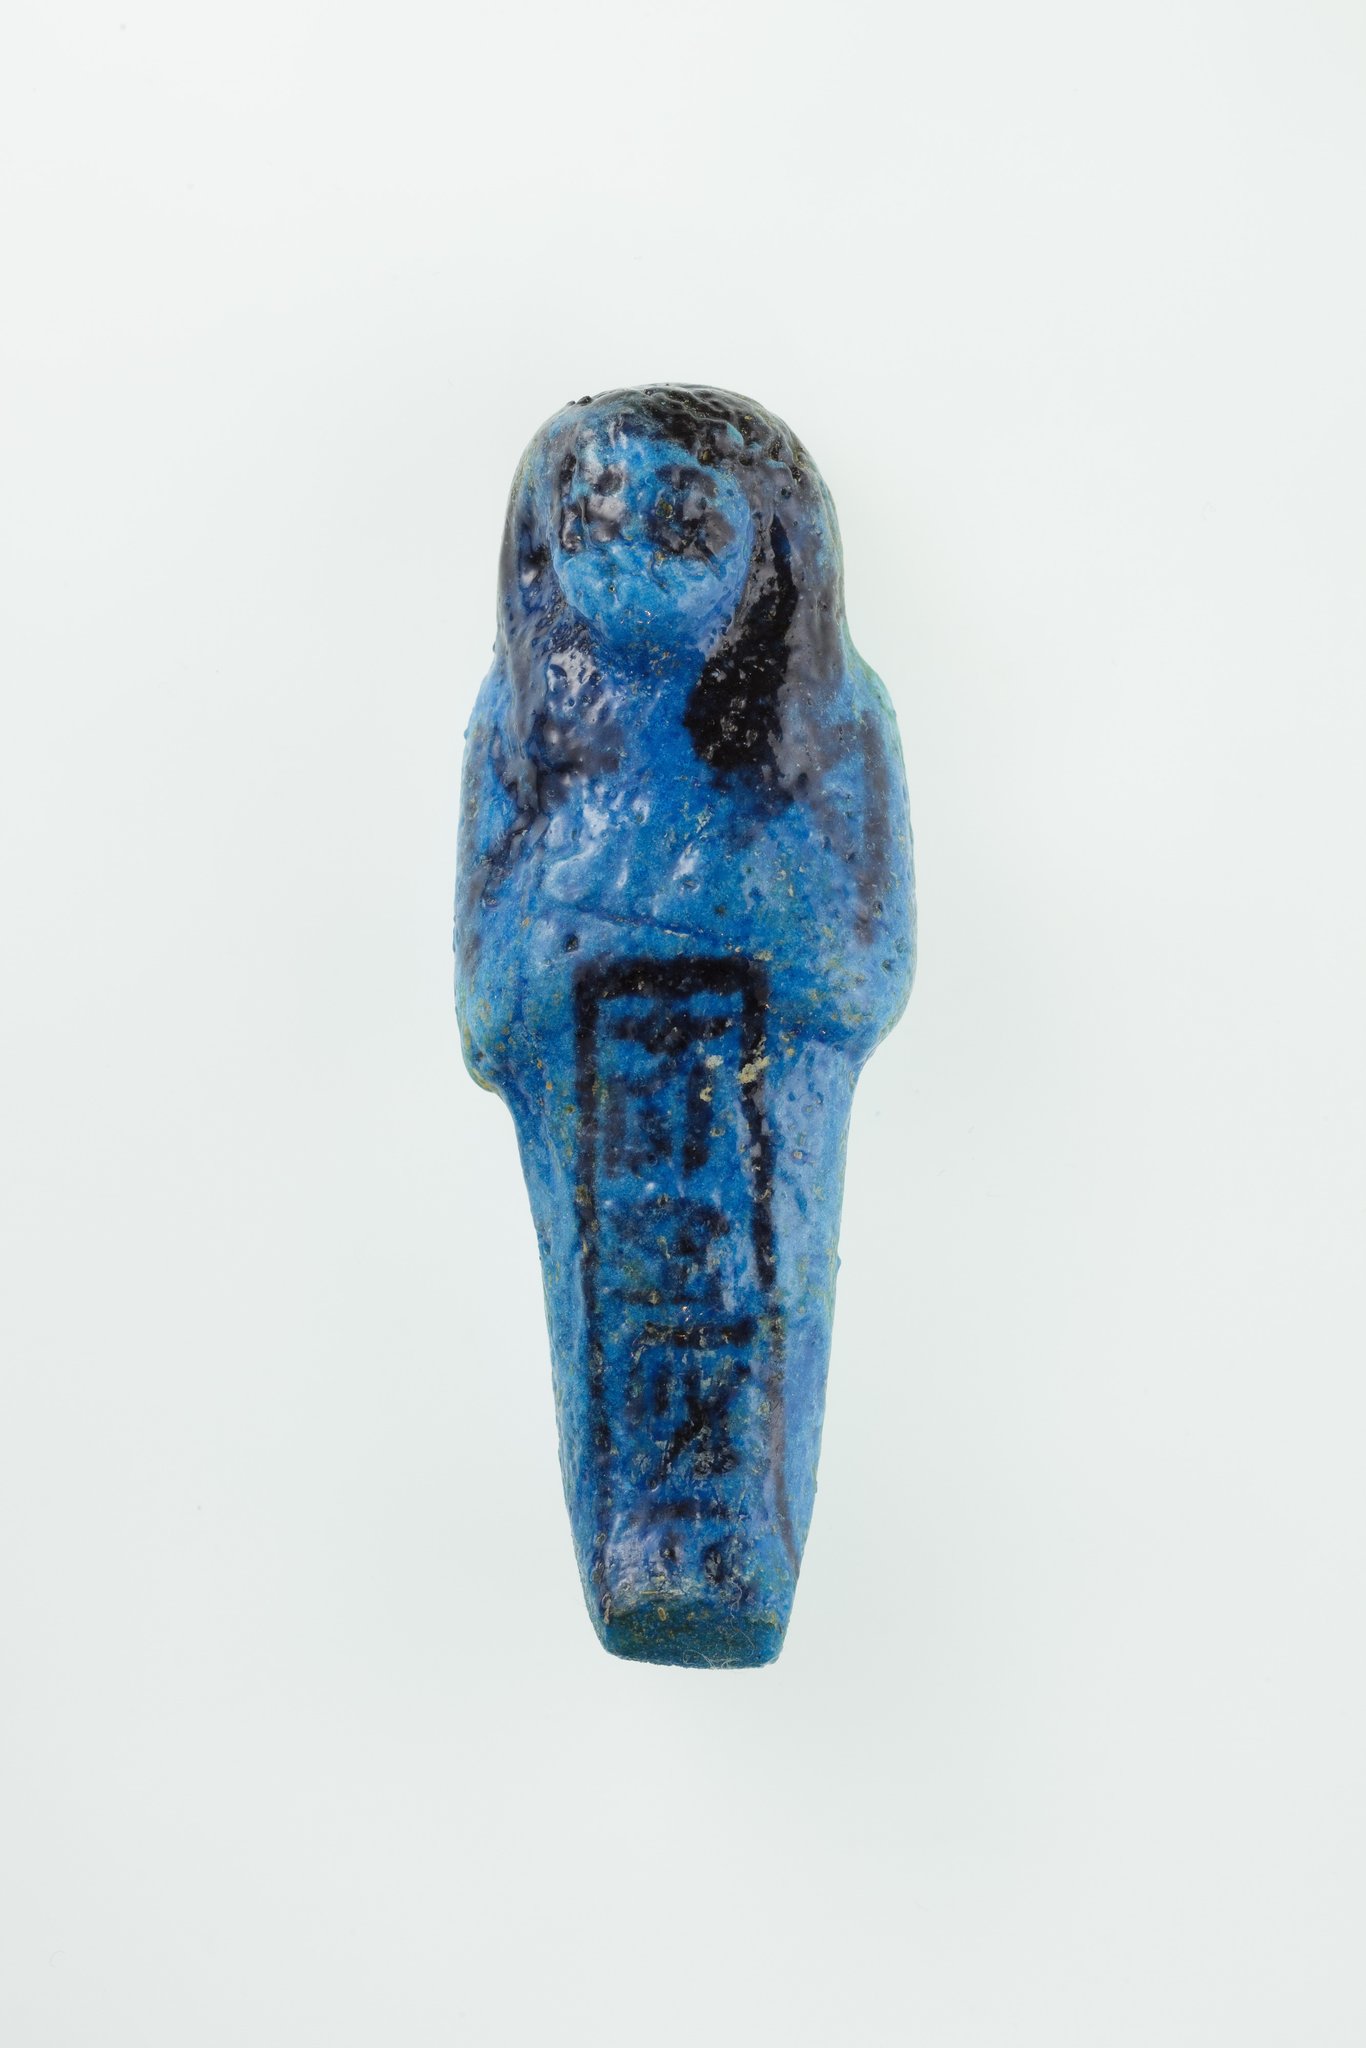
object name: shabti, worker, nauny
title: Worker Shabti of Nauny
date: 1050 BCE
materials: faience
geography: egypt